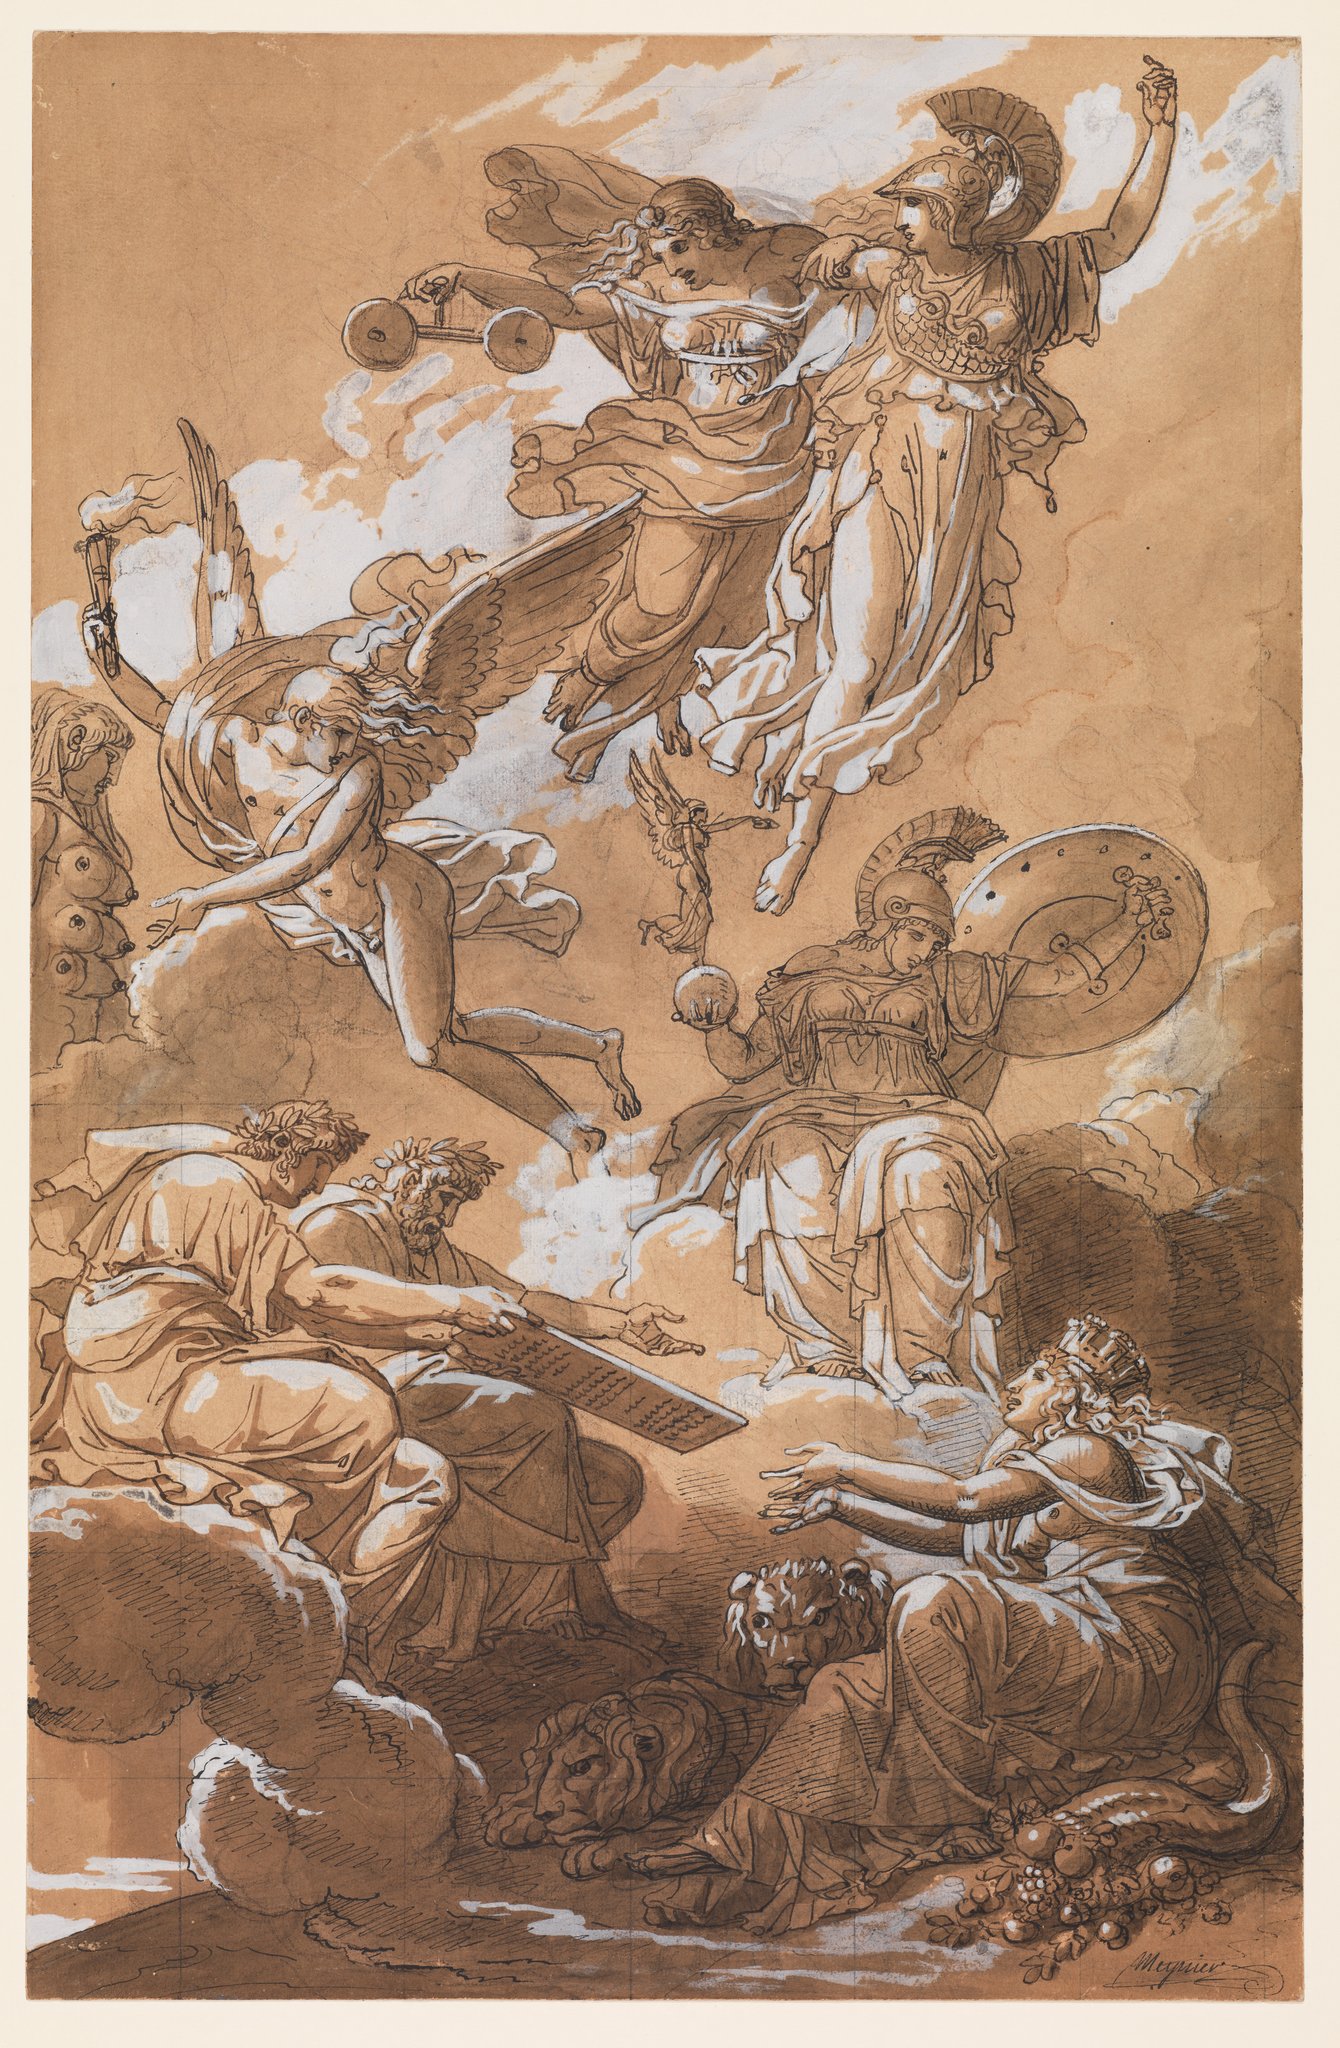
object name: drawing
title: Earth Receiving the Code of Roman Law from the Emperors Hadrian and Justinian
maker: charles meynier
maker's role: artist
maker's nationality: french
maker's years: 1768-1832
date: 1802-1803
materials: chalk, ink, paper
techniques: heightening, pen, drawing, wash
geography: france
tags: men,lions